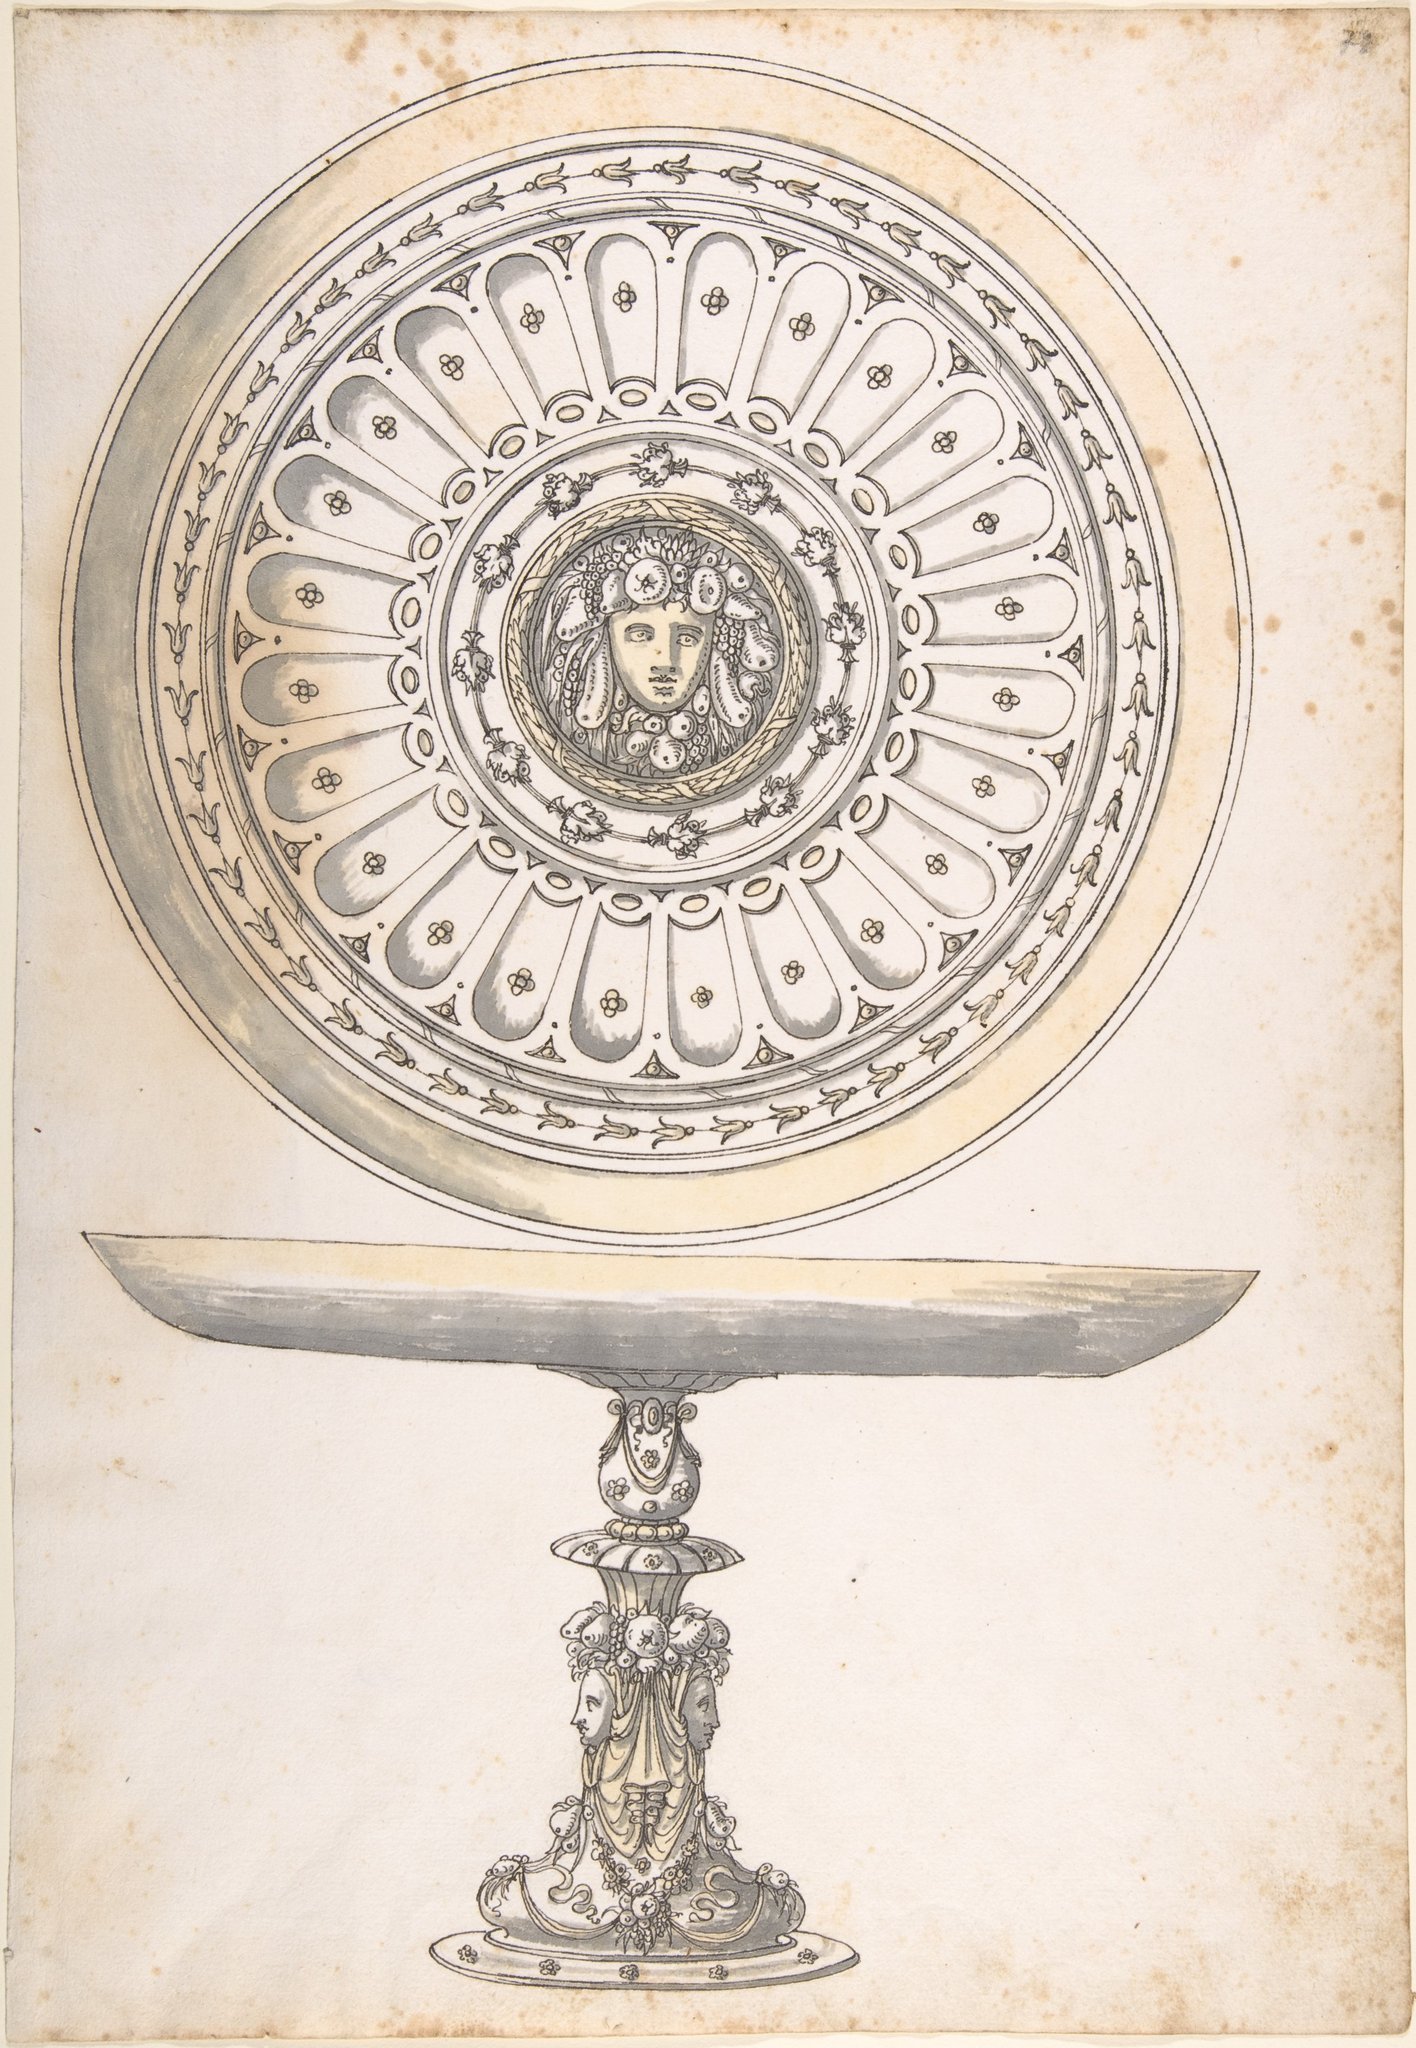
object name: drawing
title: Shallow Round Dish on tall Pedestal Decorated with Fruit and Female Masks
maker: erasmus hornick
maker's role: artist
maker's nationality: netherlandish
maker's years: 1501-1583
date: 1501-1600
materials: ink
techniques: brush, pen, wash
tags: masks,fruit,women,dishes